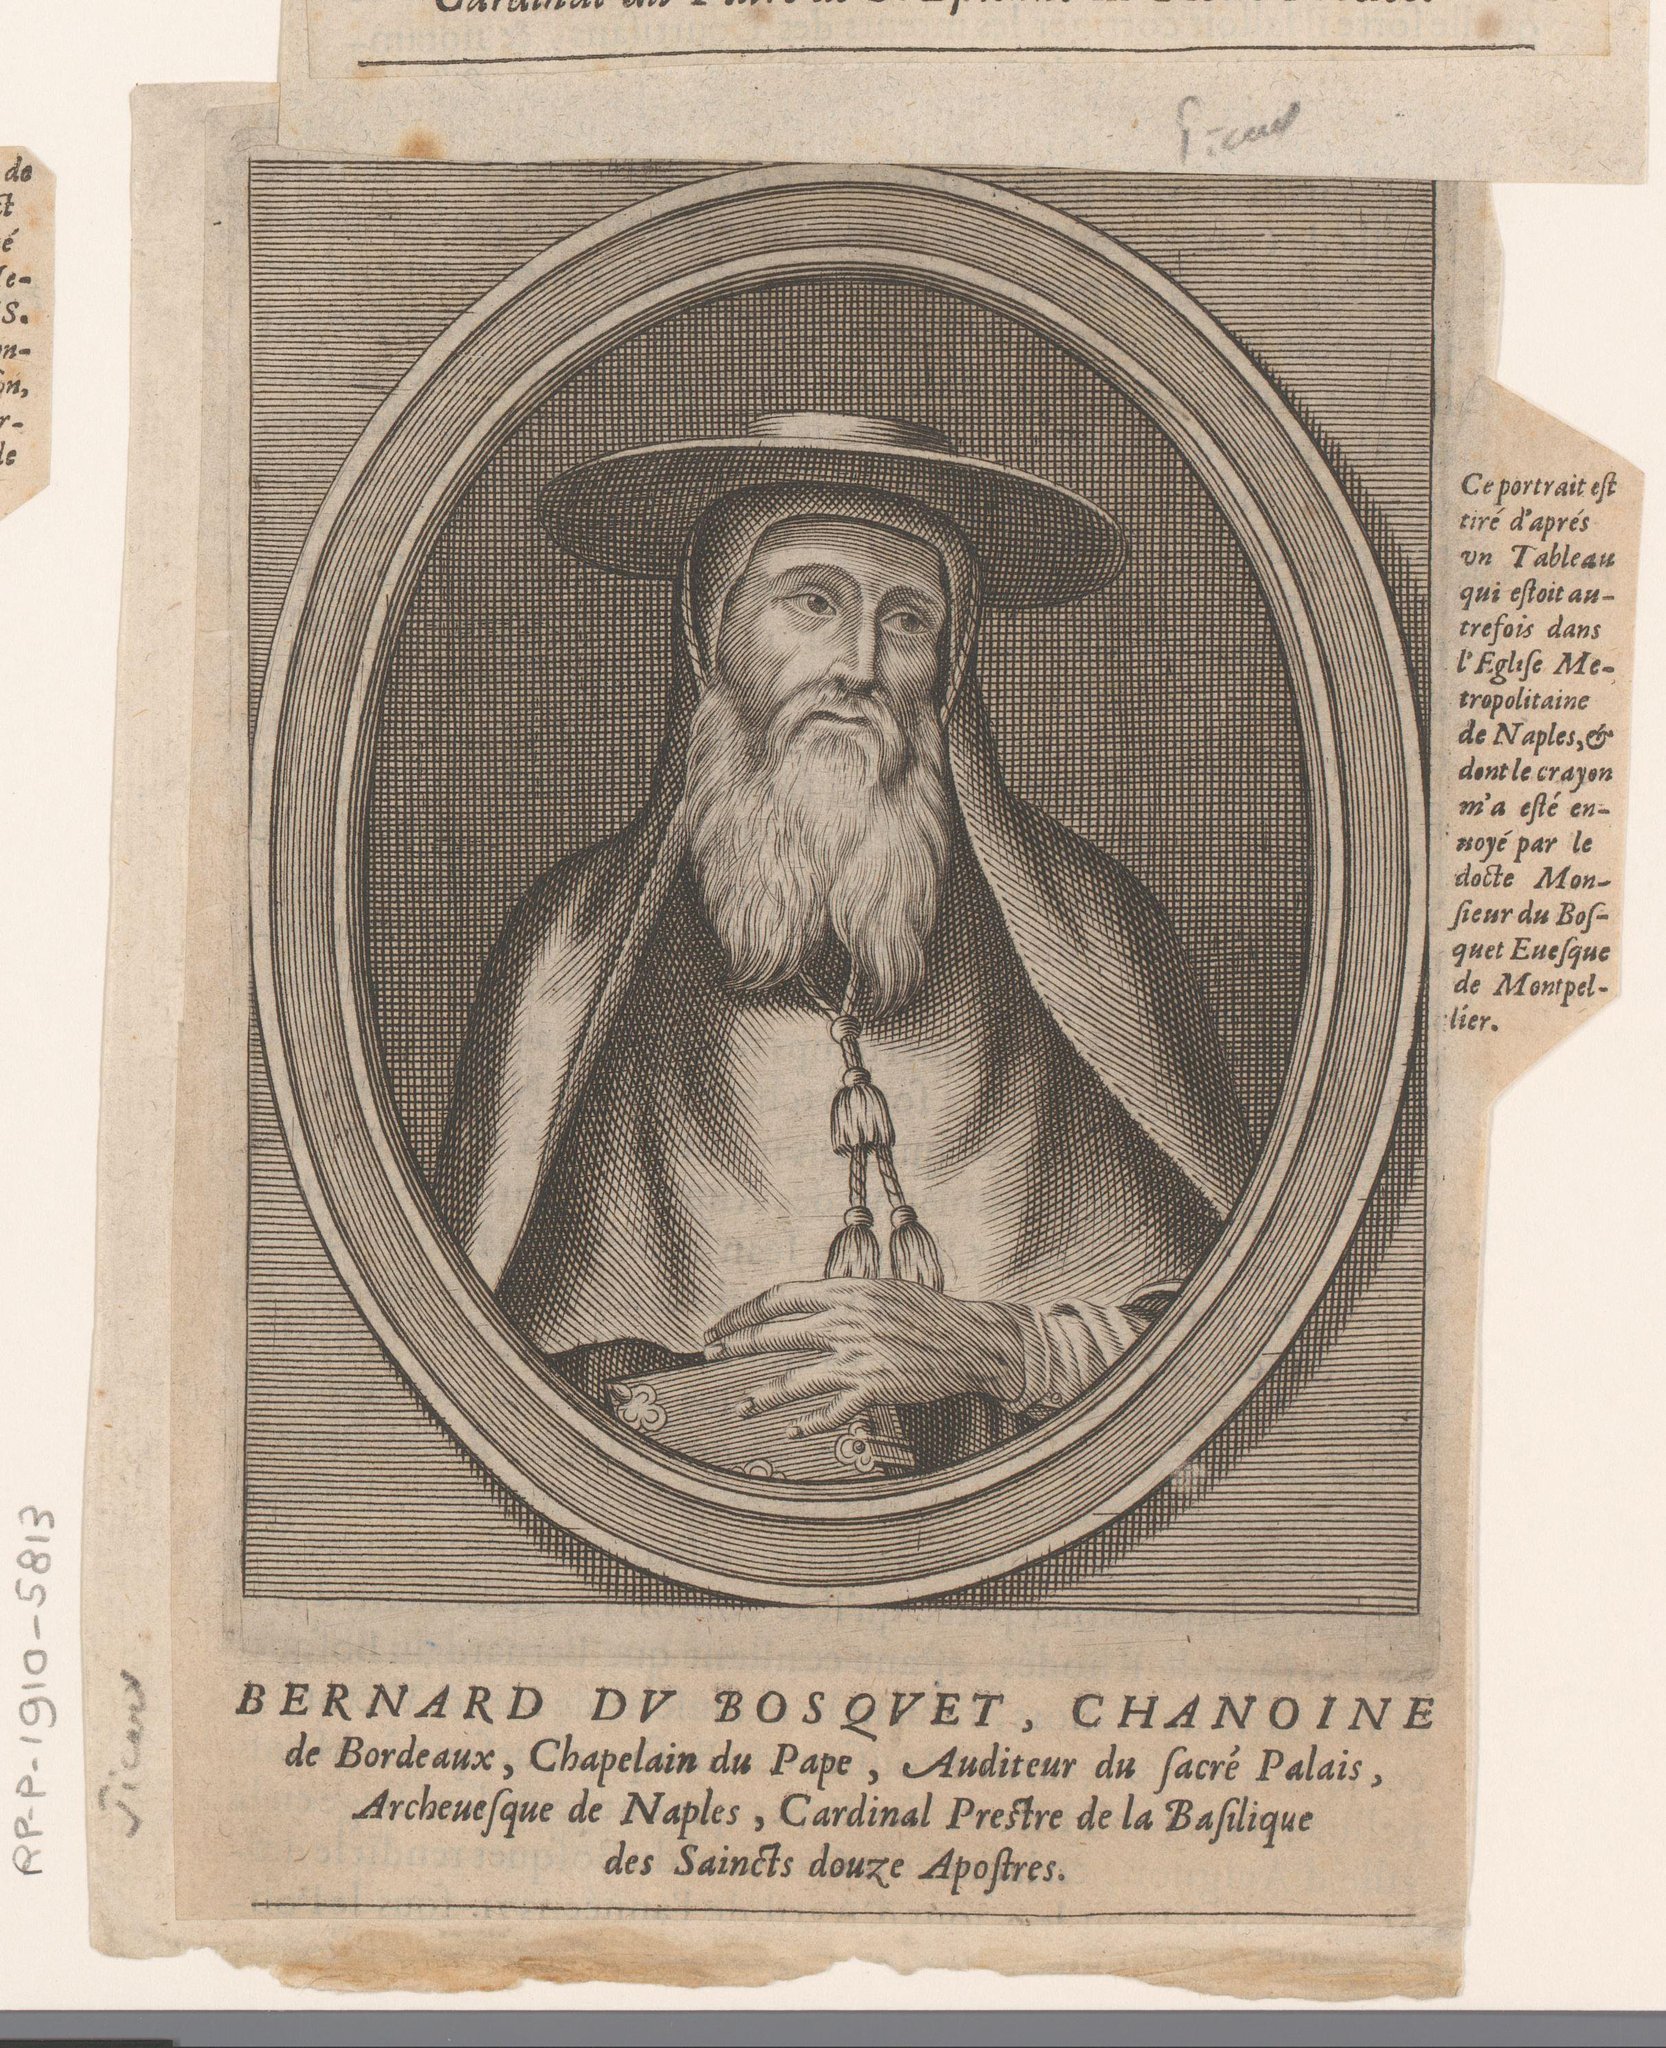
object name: print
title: Portret van Bernard du Bosquet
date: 1660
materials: paper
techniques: engraving, etching, letterpress printing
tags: cardinal, historical persons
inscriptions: collector's mark: Lugt 2228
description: Prent uit: Du Chesne, François. Histoire de tous les cardinaux françois de naissance, ou qui ont esté promeus au cardinalat. Parijs: François Du Chesne, 1660.